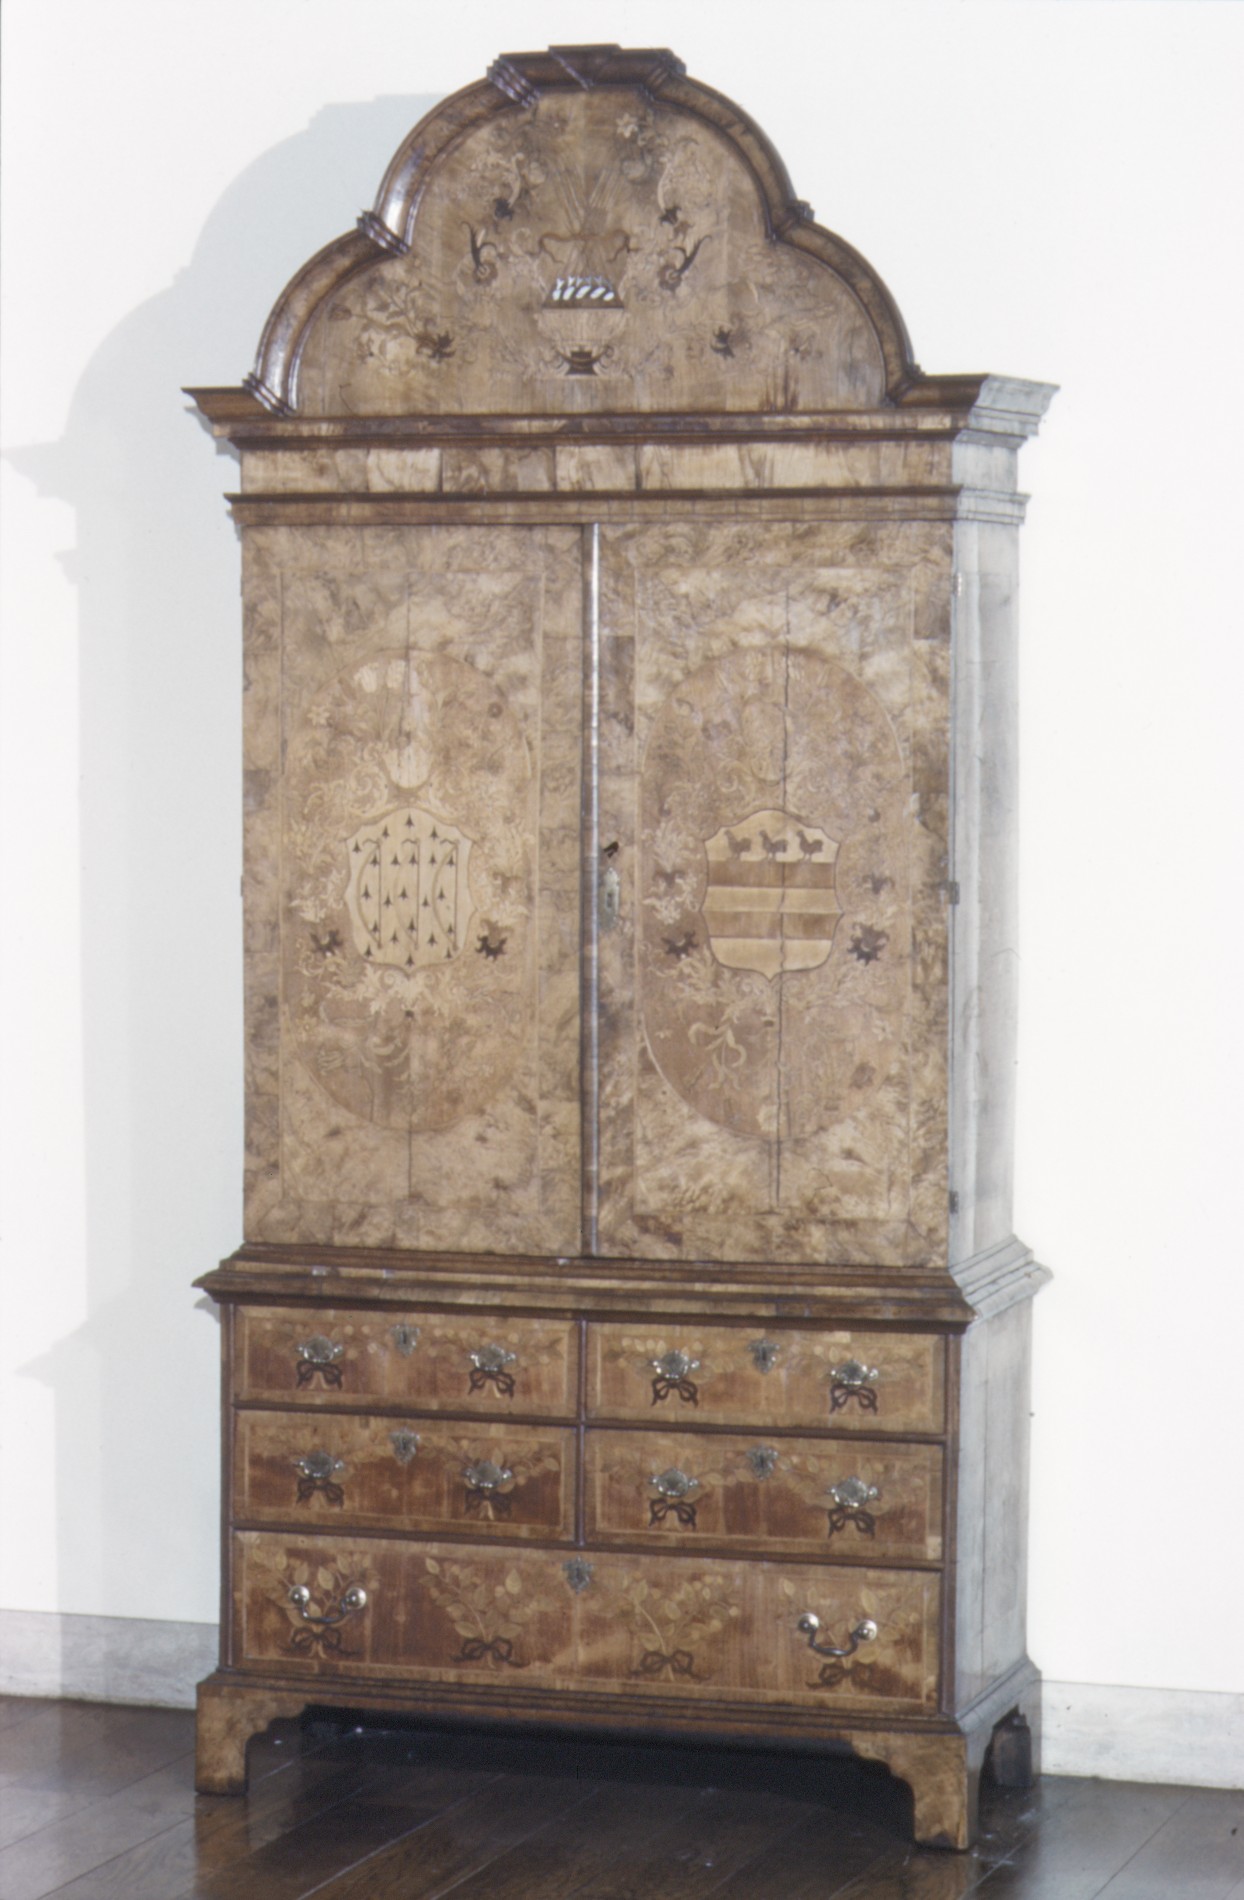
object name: cabinet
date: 1667-1700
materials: wood